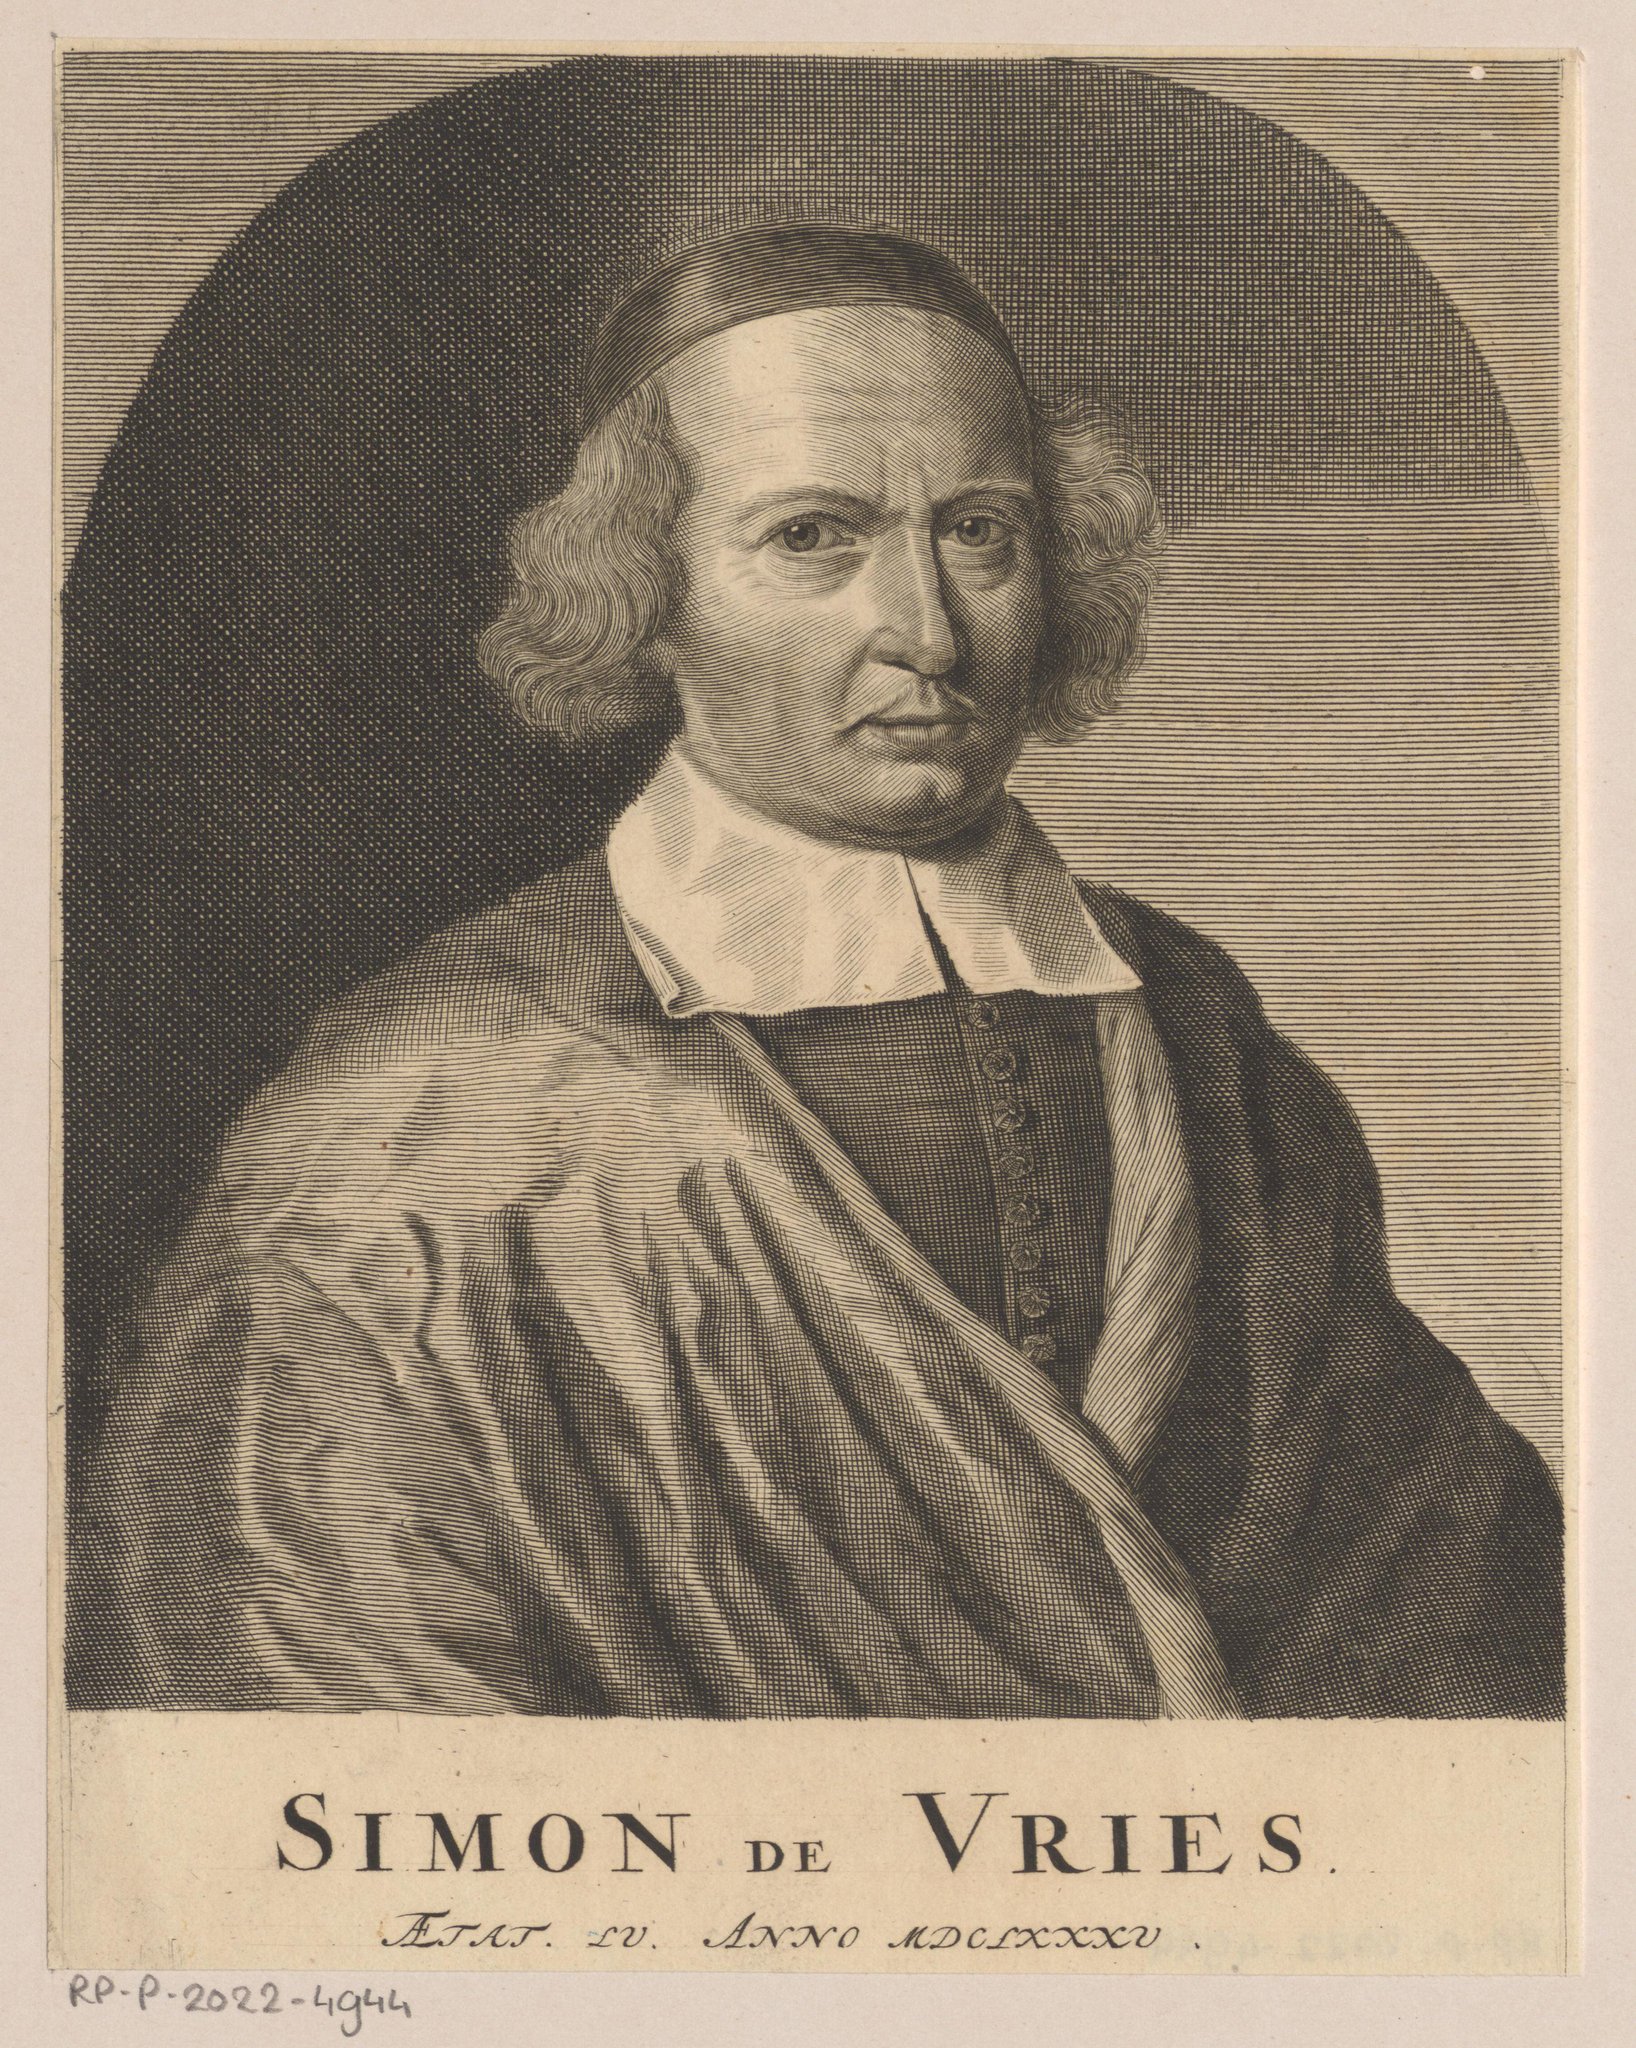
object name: print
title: Portret van Simon de Vries op 55-jarige leeftijd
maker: Anonymous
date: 1685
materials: paper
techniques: engraving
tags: simon de vries, historical persons, portrait of a writer